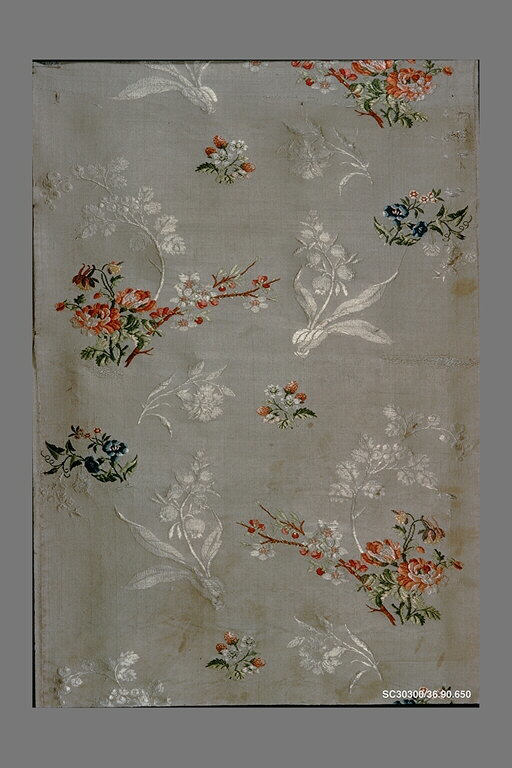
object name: piece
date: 1745-1750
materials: silk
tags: flowers